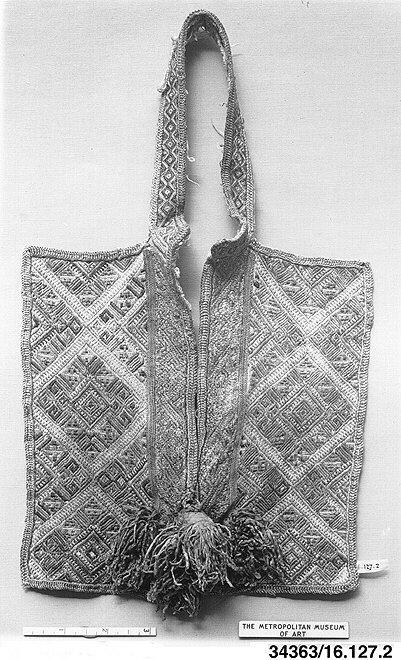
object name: collar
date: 1801-1900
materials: linen, silk